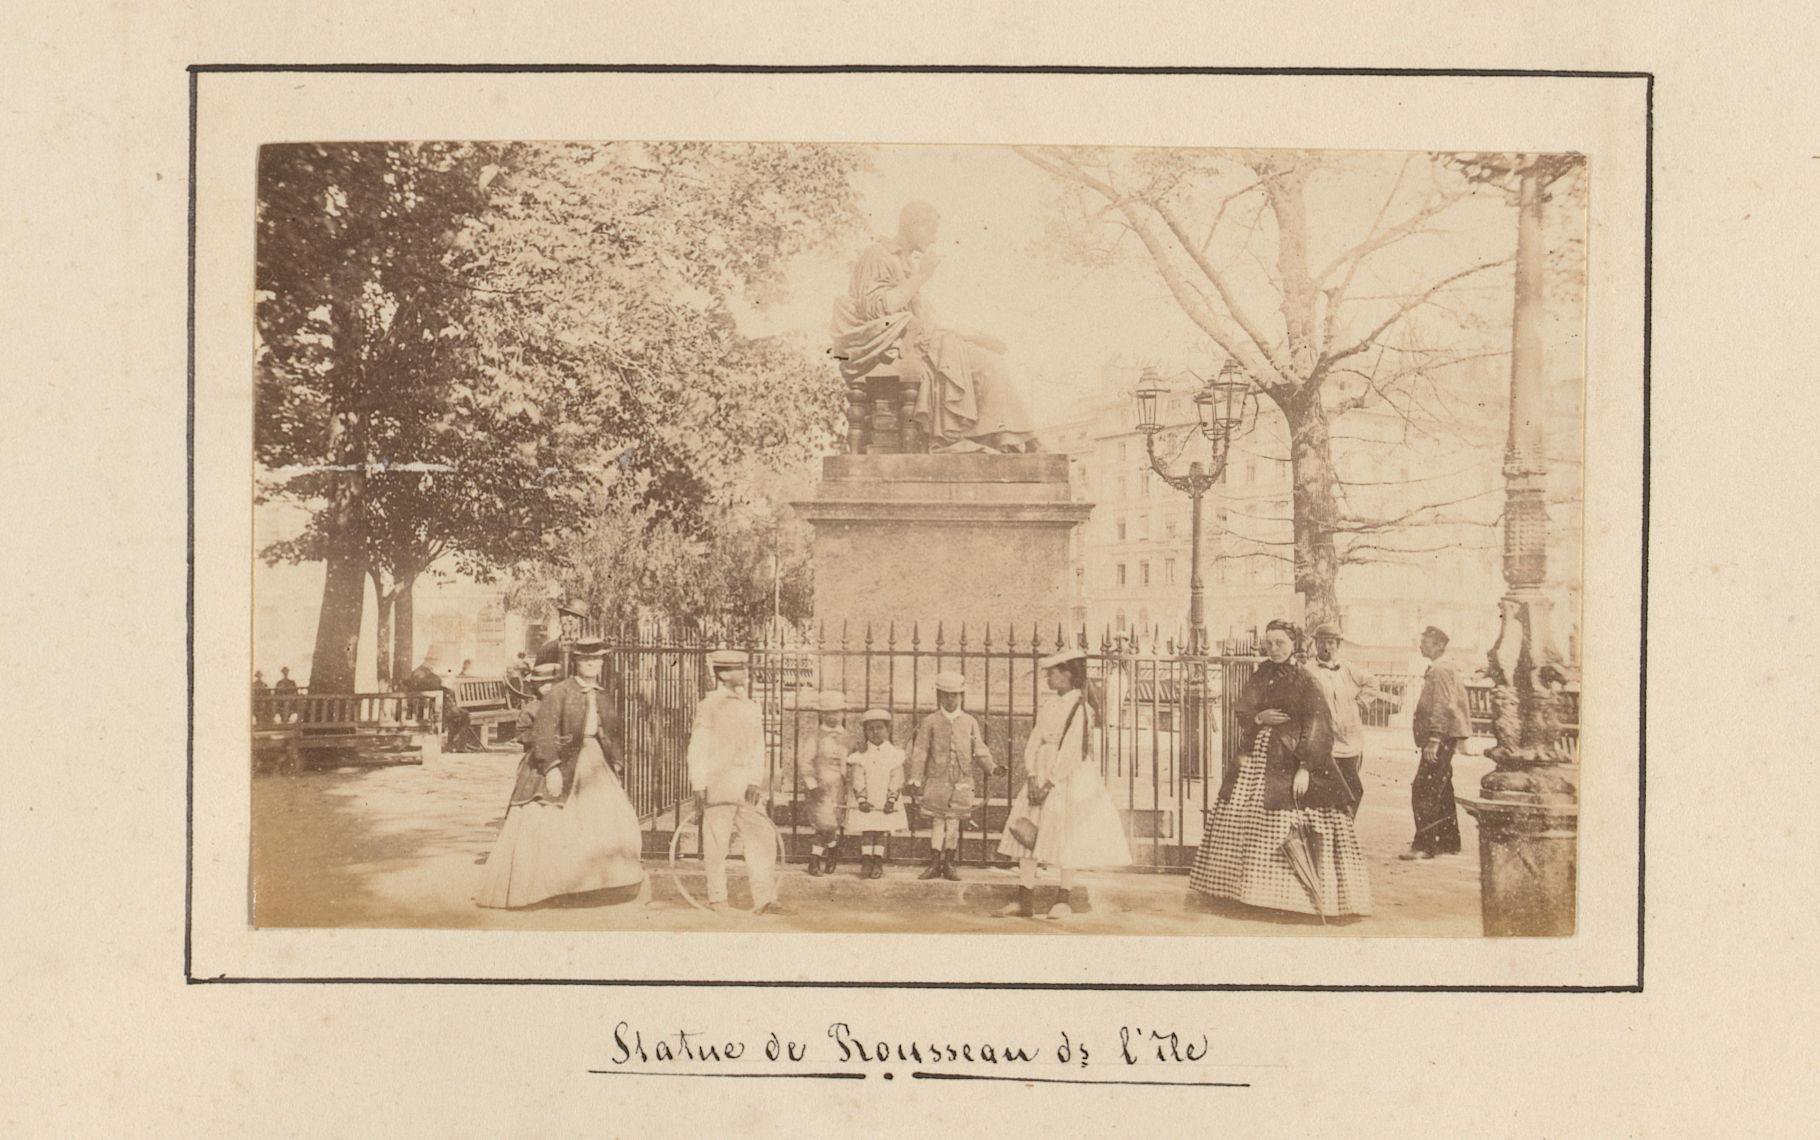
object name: photograph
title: Standbeeld van Jean-Jacques Rousseau in Genève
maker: auguste garcin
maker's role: fotograaf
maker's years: 1816-1895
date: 1870-1890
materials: paper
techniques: albumen print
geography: geneva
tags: monument, statue